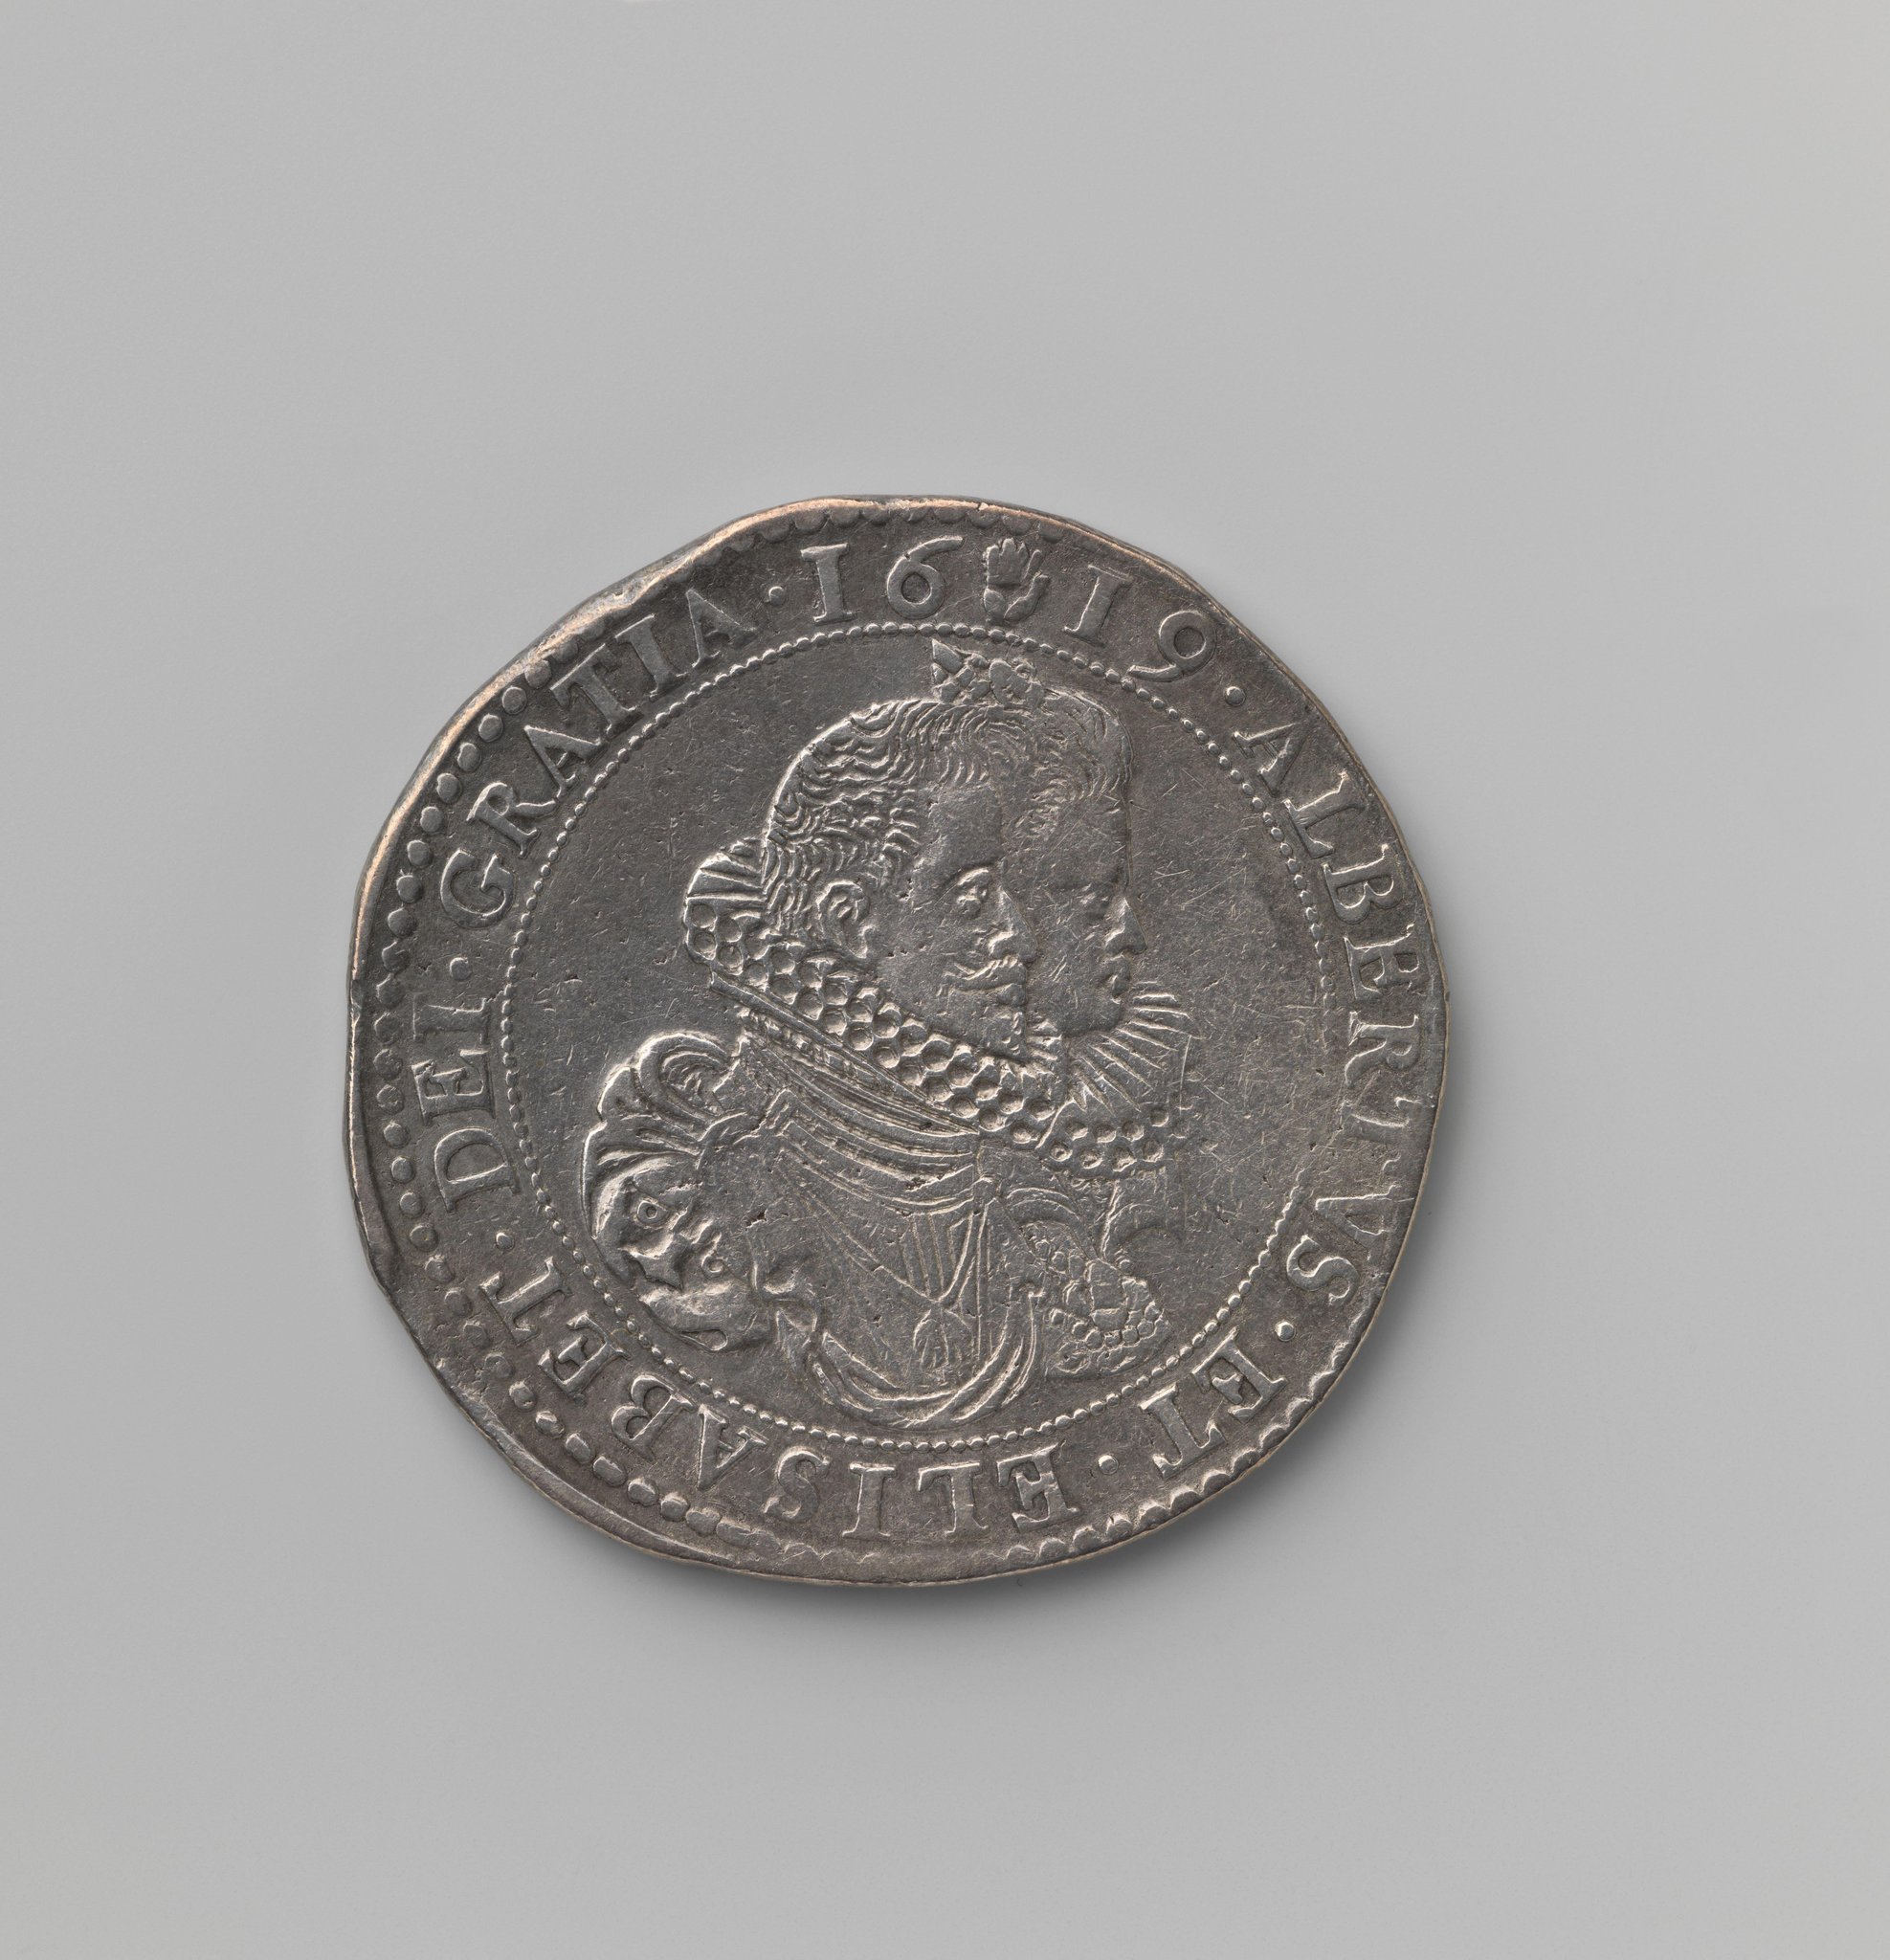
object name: ducatoon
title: Brabant, Albert en Isabella, dukaton, 1619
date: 1619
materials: silver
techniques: striking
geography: antwerp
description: Zilveren munt. Voorzijde: portretten van Albert en Isabella naar rechts. Jaartal, waartussen hand, in omschrift. Keerzijde: door twee leeuwen gehouden gekroond samengesteld wapenschild. Onder wapenschild twee naar elkaar gekeerde vuurijzers met vonken, waaronder gulden vlies.